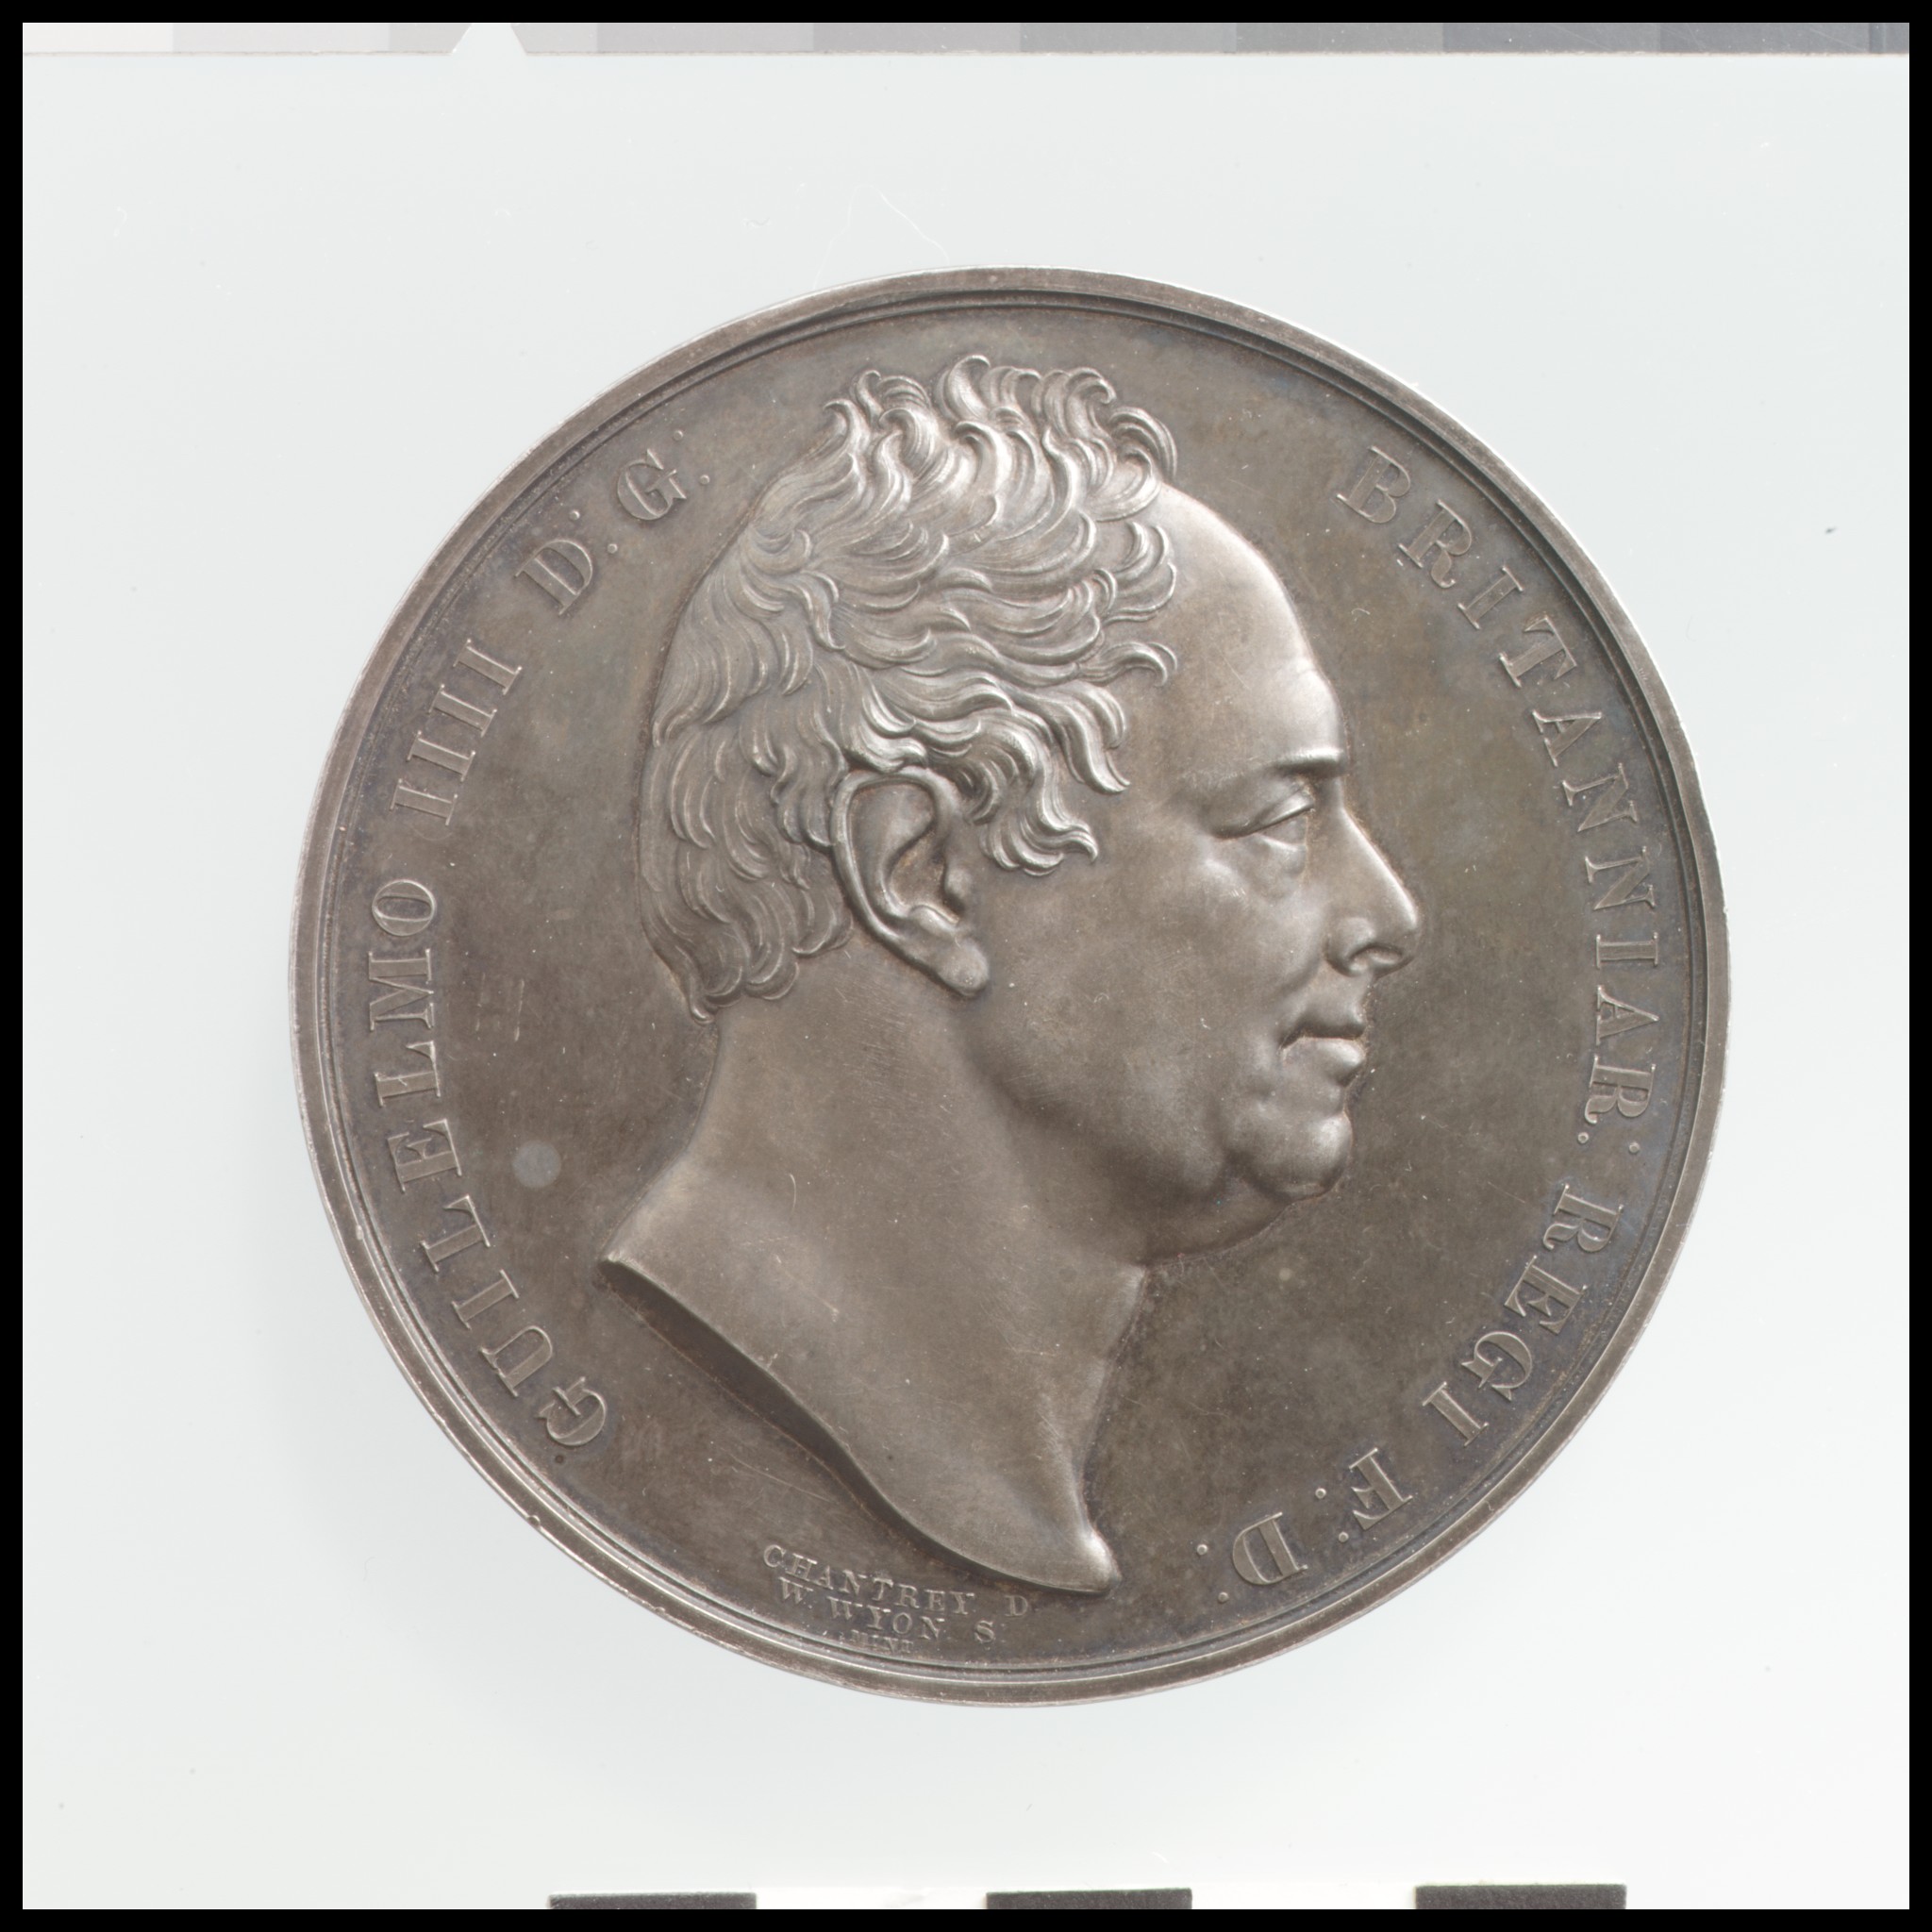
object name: accession medal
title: William IV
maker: william wyon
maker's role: artist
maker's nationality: british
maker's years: 1795-1851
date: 1830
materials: silver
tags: kings,profiles